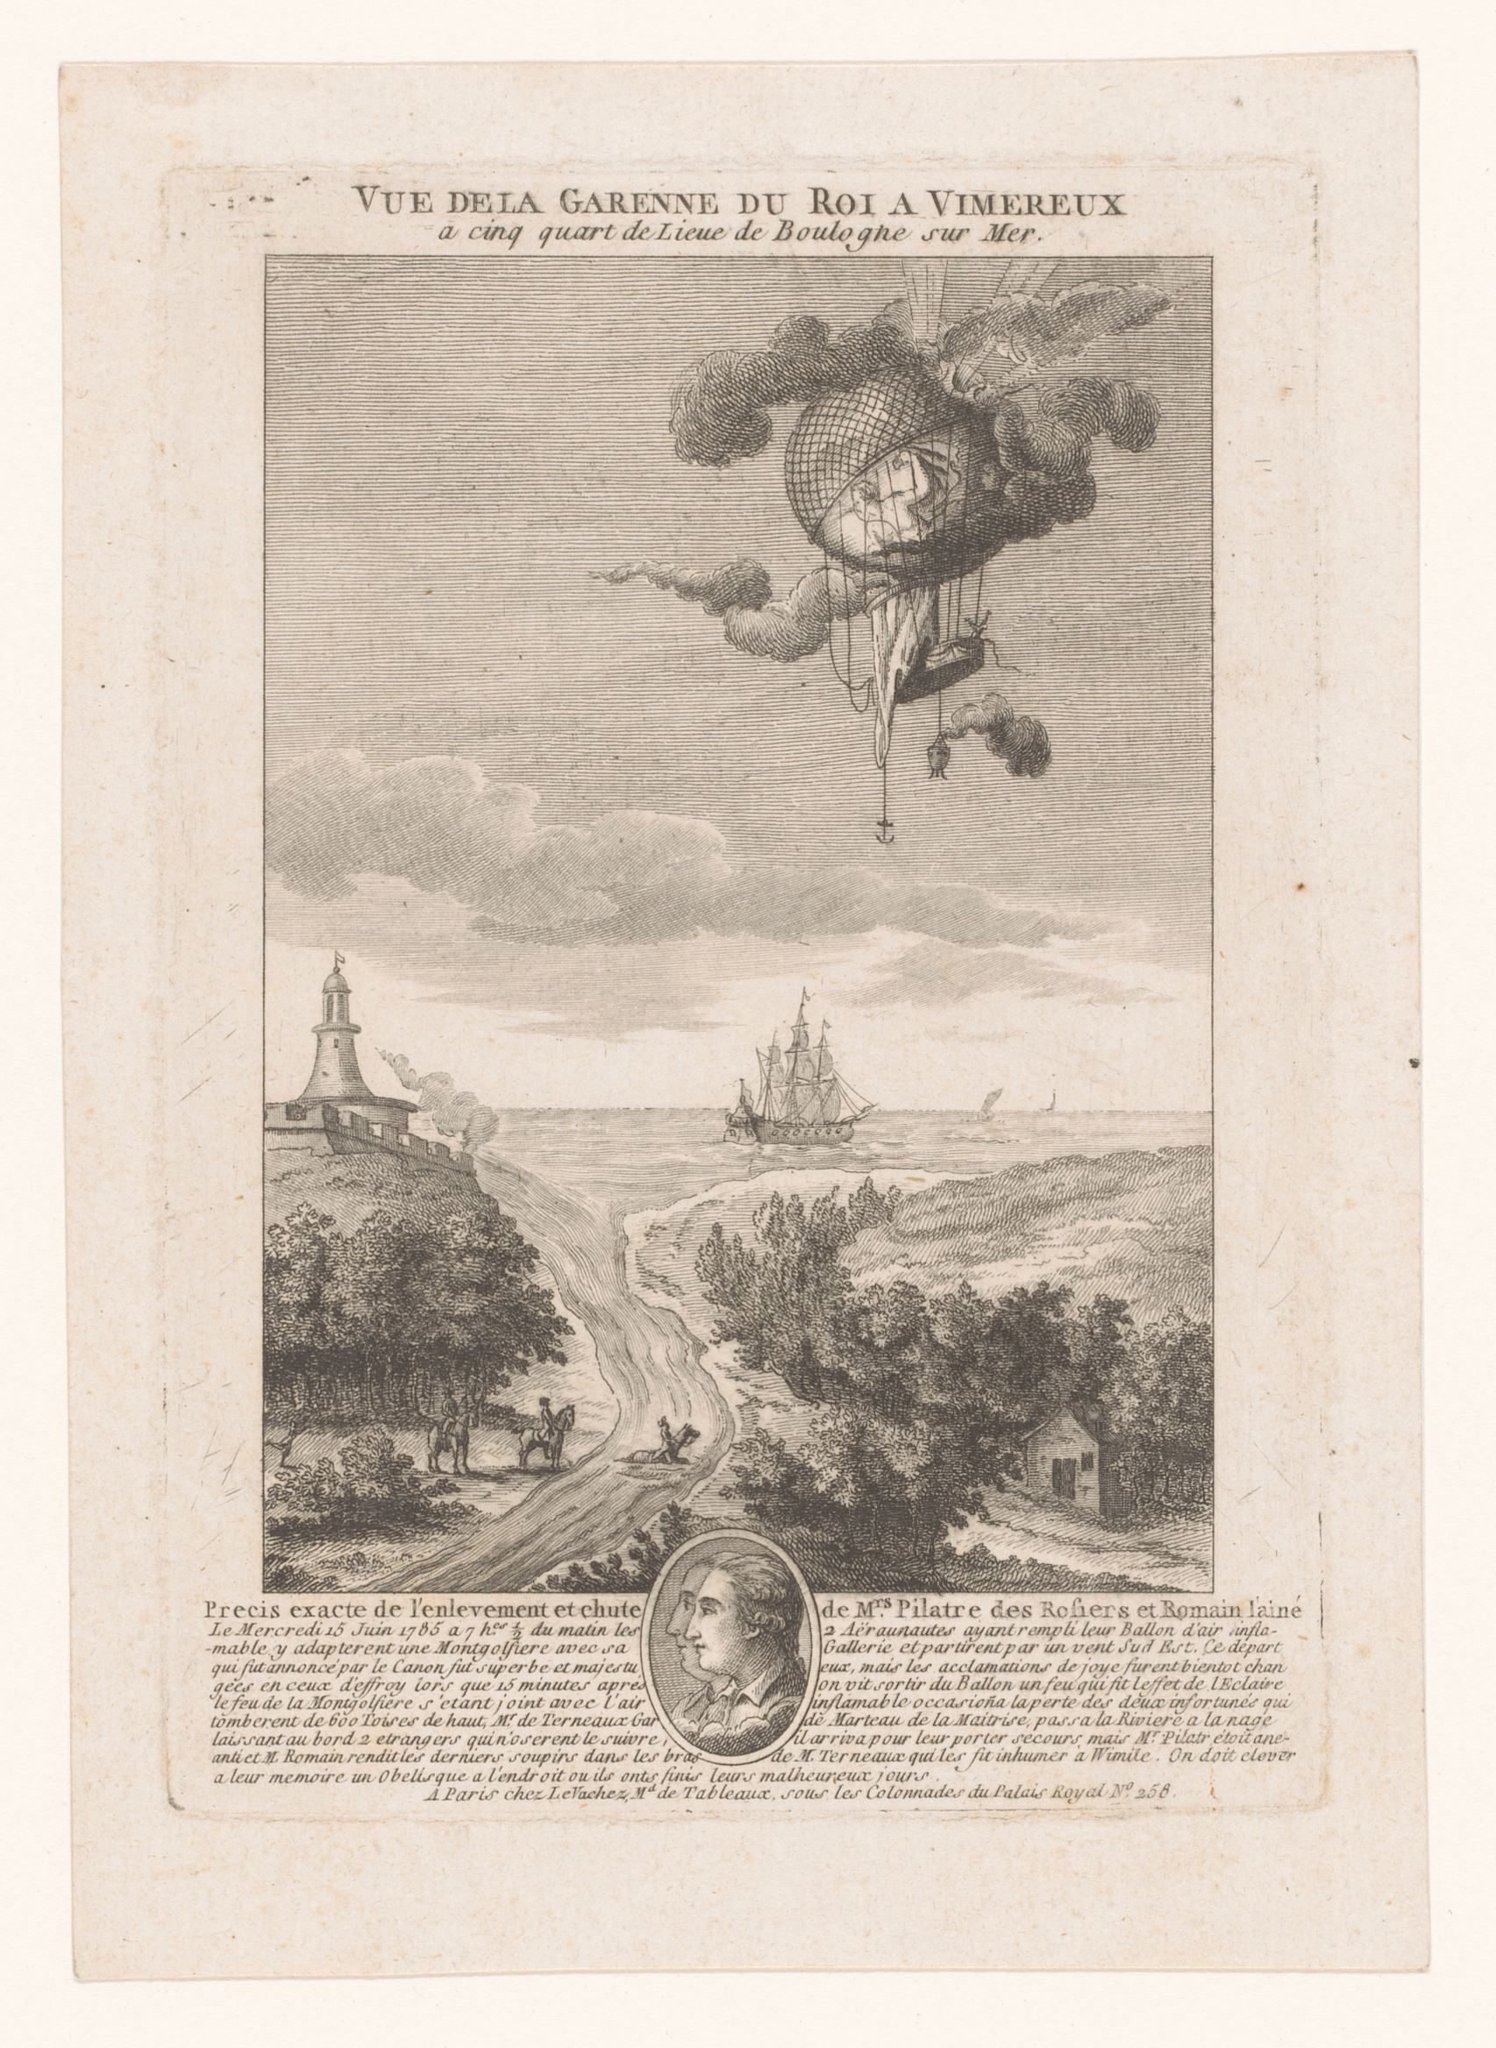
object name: print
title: Vue de la Garenne du Roi à Vimeraux à cinq quart de lieu de Boulogne sur Mer - Précis exacte de l'enlèvement et chute de Mrs Pilare des Rosiers et Romain l'aîné en 1785 (...)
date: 1785-1790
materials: paper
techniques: engraving, etching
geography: paris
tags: balloon (aviation) (+ accident, collision, crash ~ traffic and transport), historical persons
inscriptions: collector's mark: Lugt 2760, collector's mark: Lugt 2228